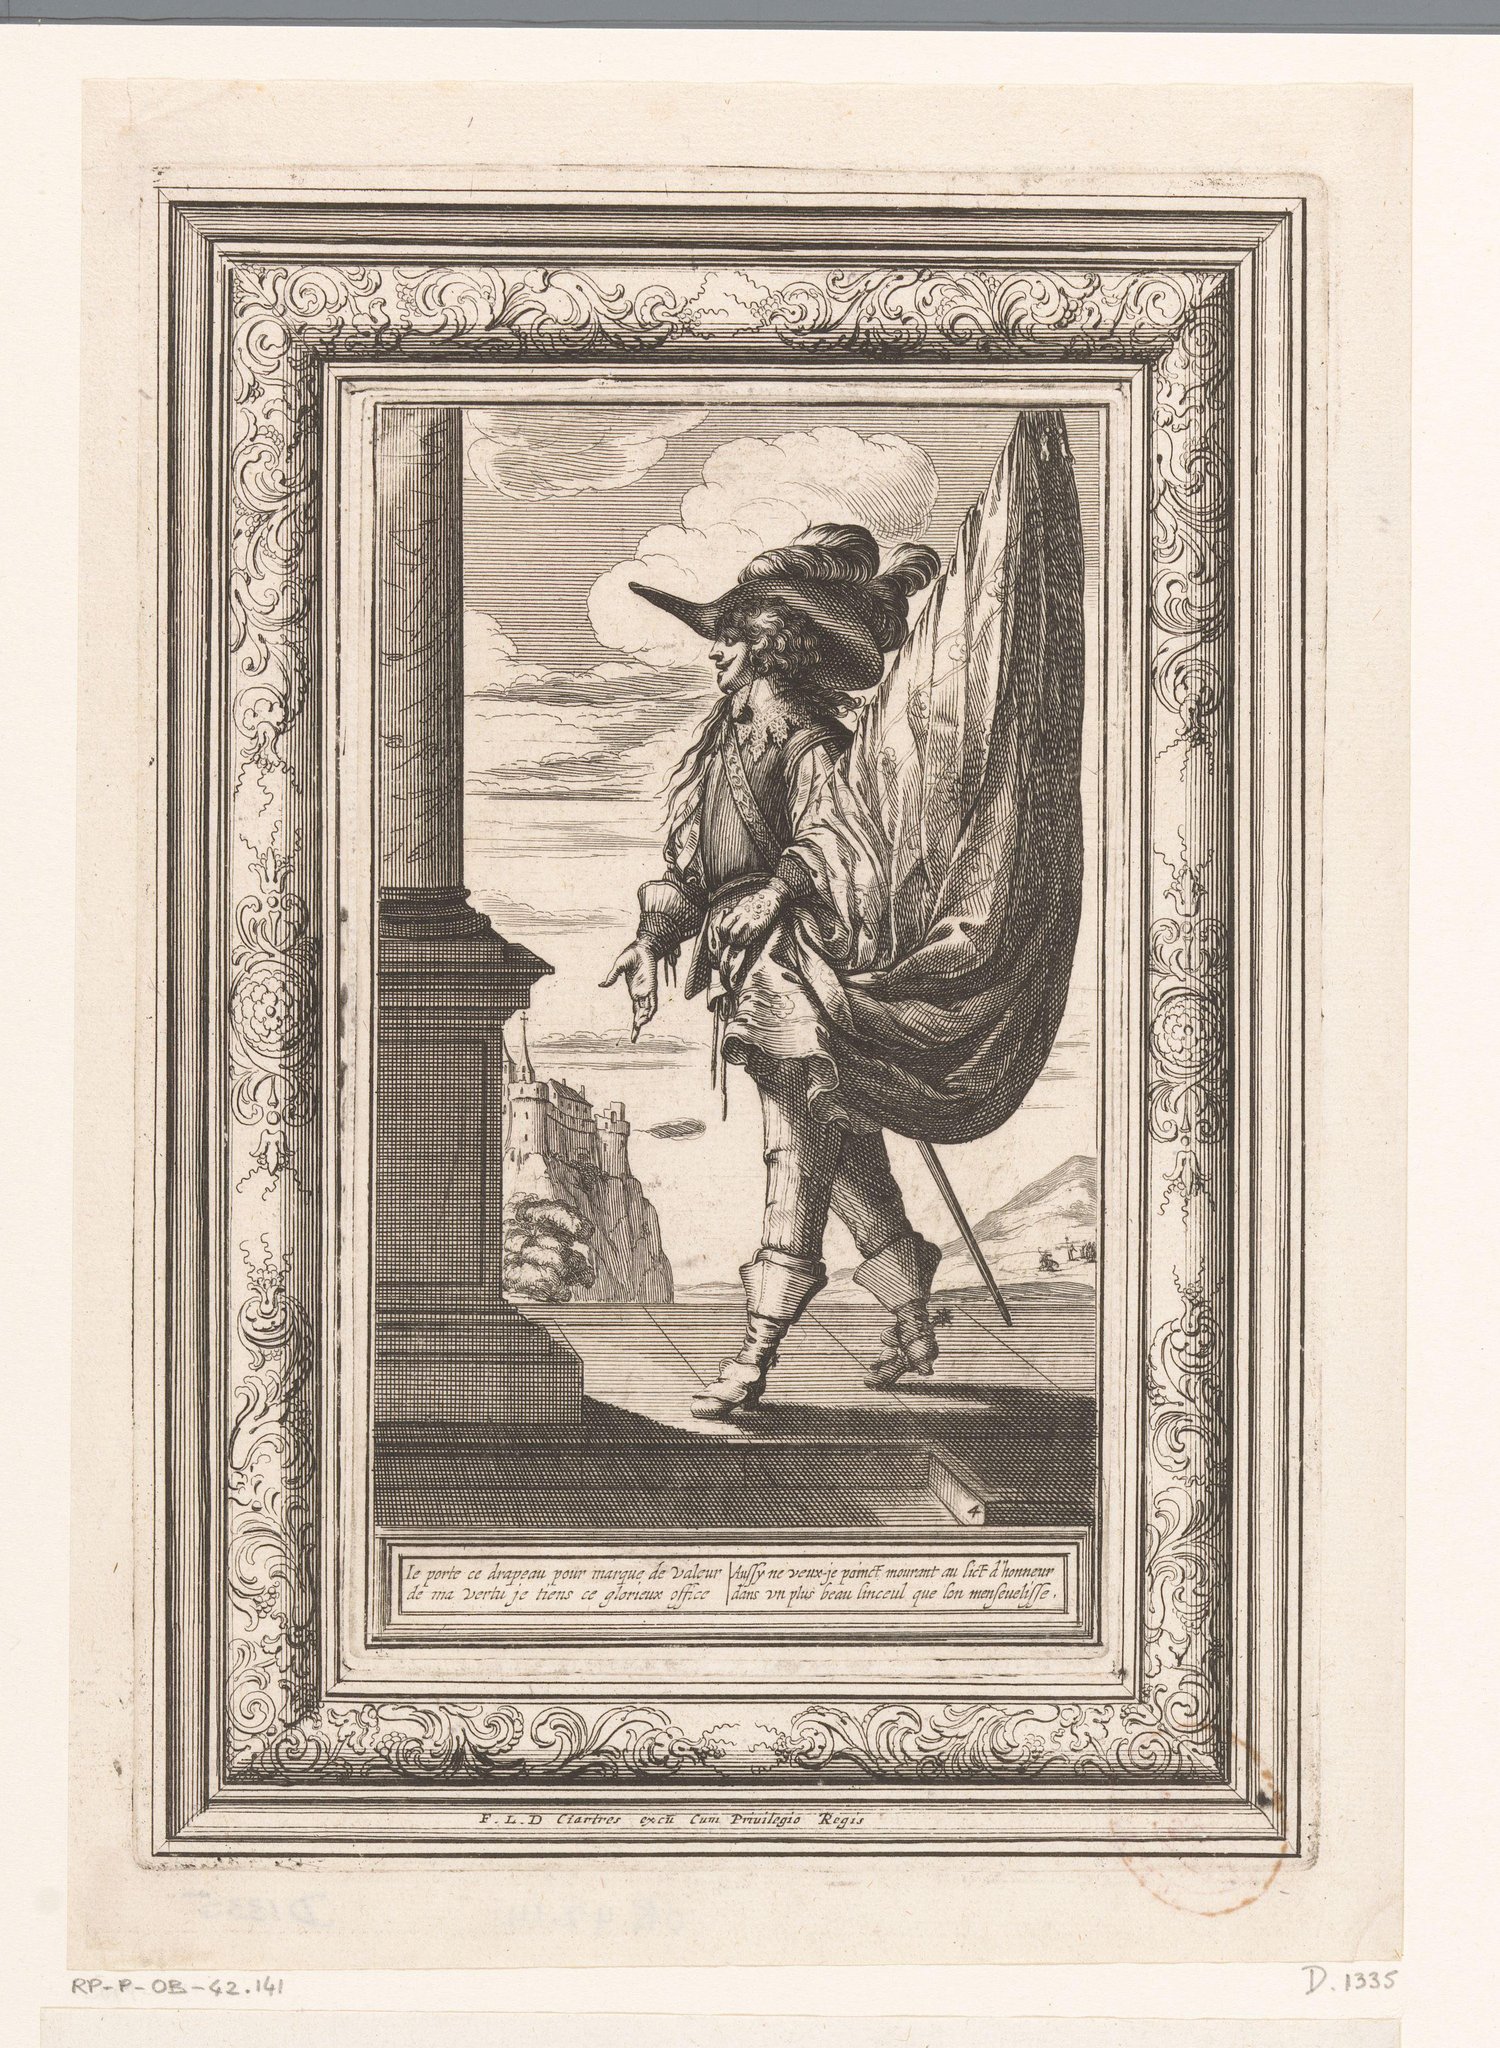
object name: costume print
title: Figures Au naturel tant des Vestements que des postures des Gardes Francoises du Roy Tres chrestien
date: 1639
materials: paper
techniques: engraving, etching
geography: paris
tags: standard-bearer, flag-bearer, (military) standard-bearer, clothes, costume (+ men's clothes), the soldier; the soldier's life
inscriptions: collector's mark: Lugt 240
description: Maakt deel uit van een serie met acht kostuumprenten en een titelprent van de Franse koninklijke garde, in de voor hen passende kleding. De serie werd in 1632 uitgegeven in Parijs door Melchior Tavernier. Een tweede staat werd uitgegeven door François Langlois in 1639.